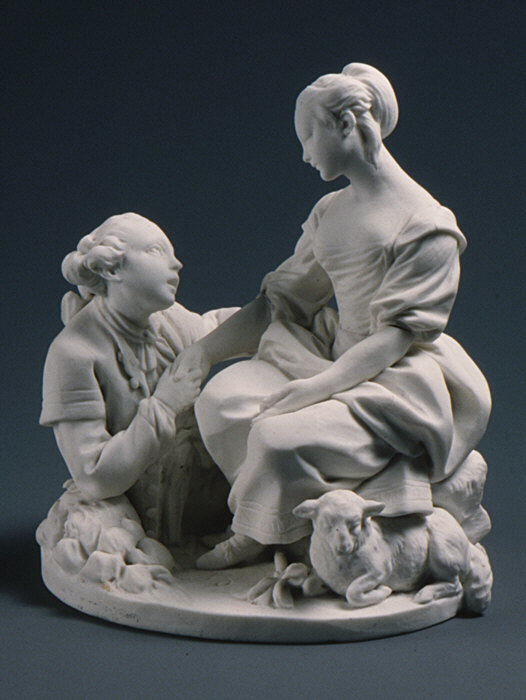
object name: figure group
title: The Shepherdess of the Alps (La Bergère des Alpes)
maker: sèvres manufactory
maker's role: manufactory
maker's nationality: french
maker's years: 1740-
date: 1766-1773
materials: biscuit, paste, porcelain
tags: men,women,sheep,shepherds